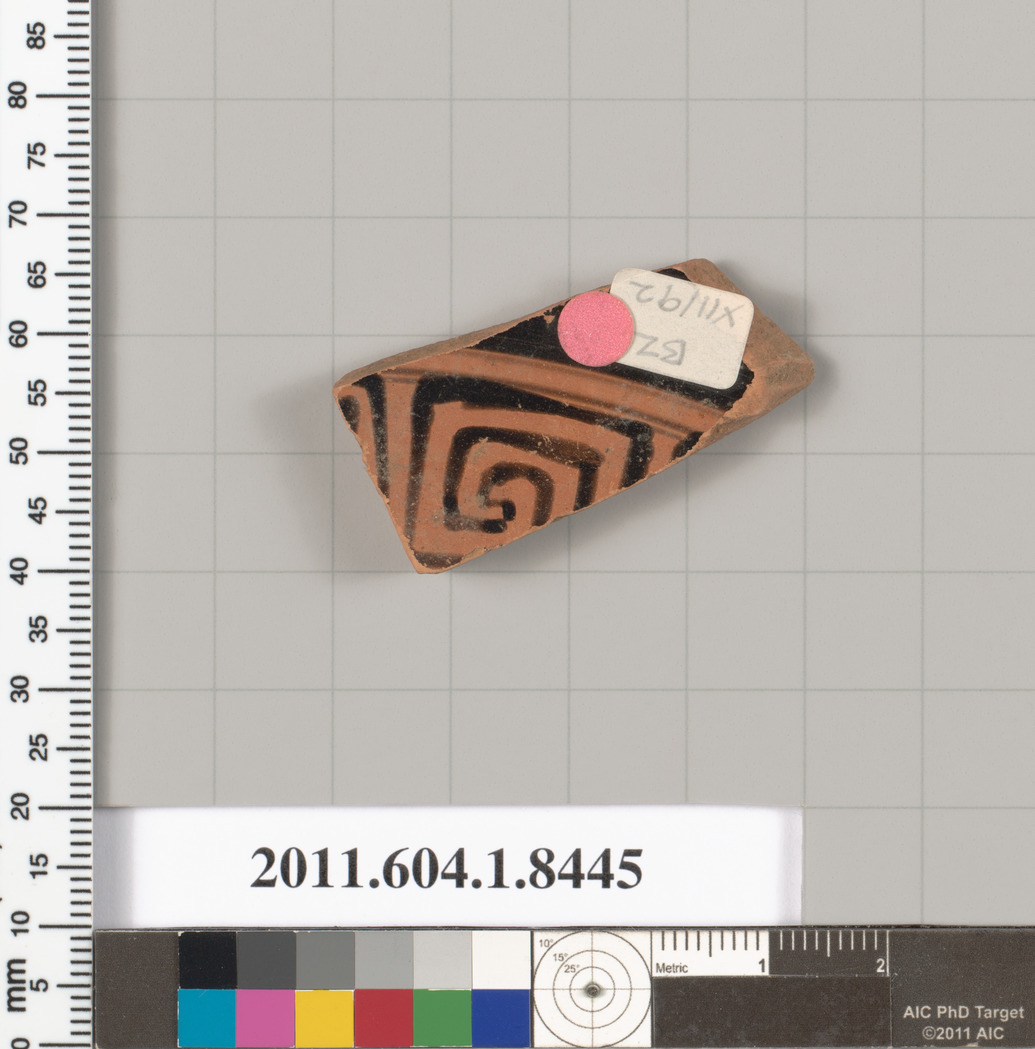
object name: kylix fragment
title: Terracotta fragment of a kylix (drinking cup)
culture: greek, attic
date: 375-351 BCE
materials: terracotta